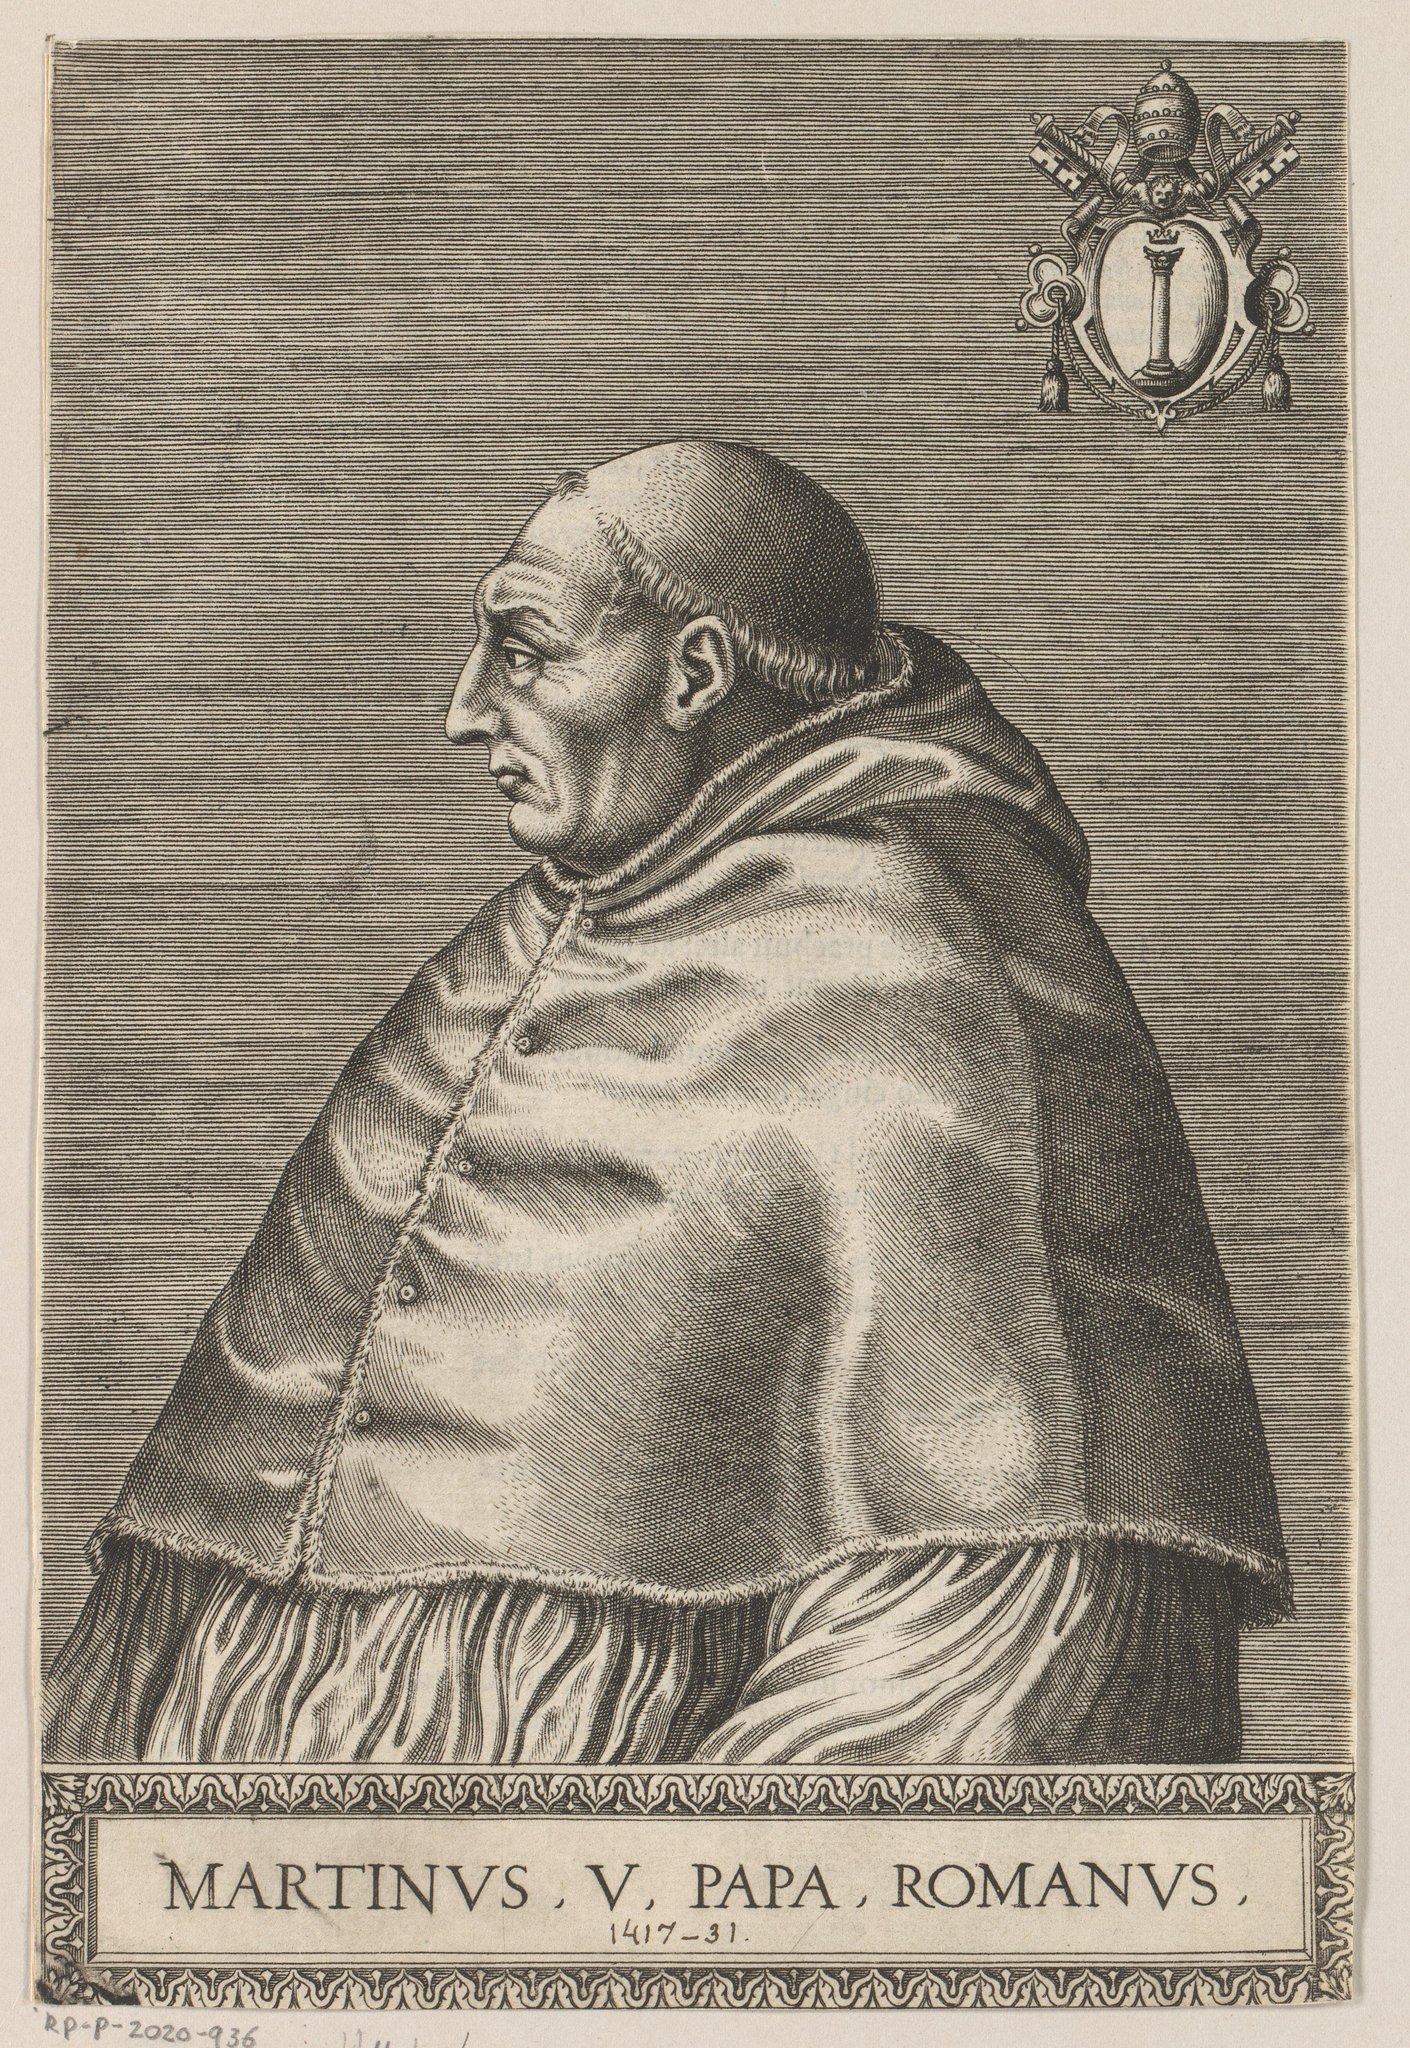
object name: book illustration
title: Martinus V papa Romanus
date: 1568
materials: paper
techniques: engraving, letterpress printing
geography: rome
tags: rome, clergyman, historical persons, pope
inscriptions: inscription: ‘1417-31’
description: Prent uit: Panvinio, Onofrio. 27 pontificum maximorum elogia et imagines accuratissime ad uiuum aeneis typeis delineatae. Rome: Antonio Lafreri, 1568.